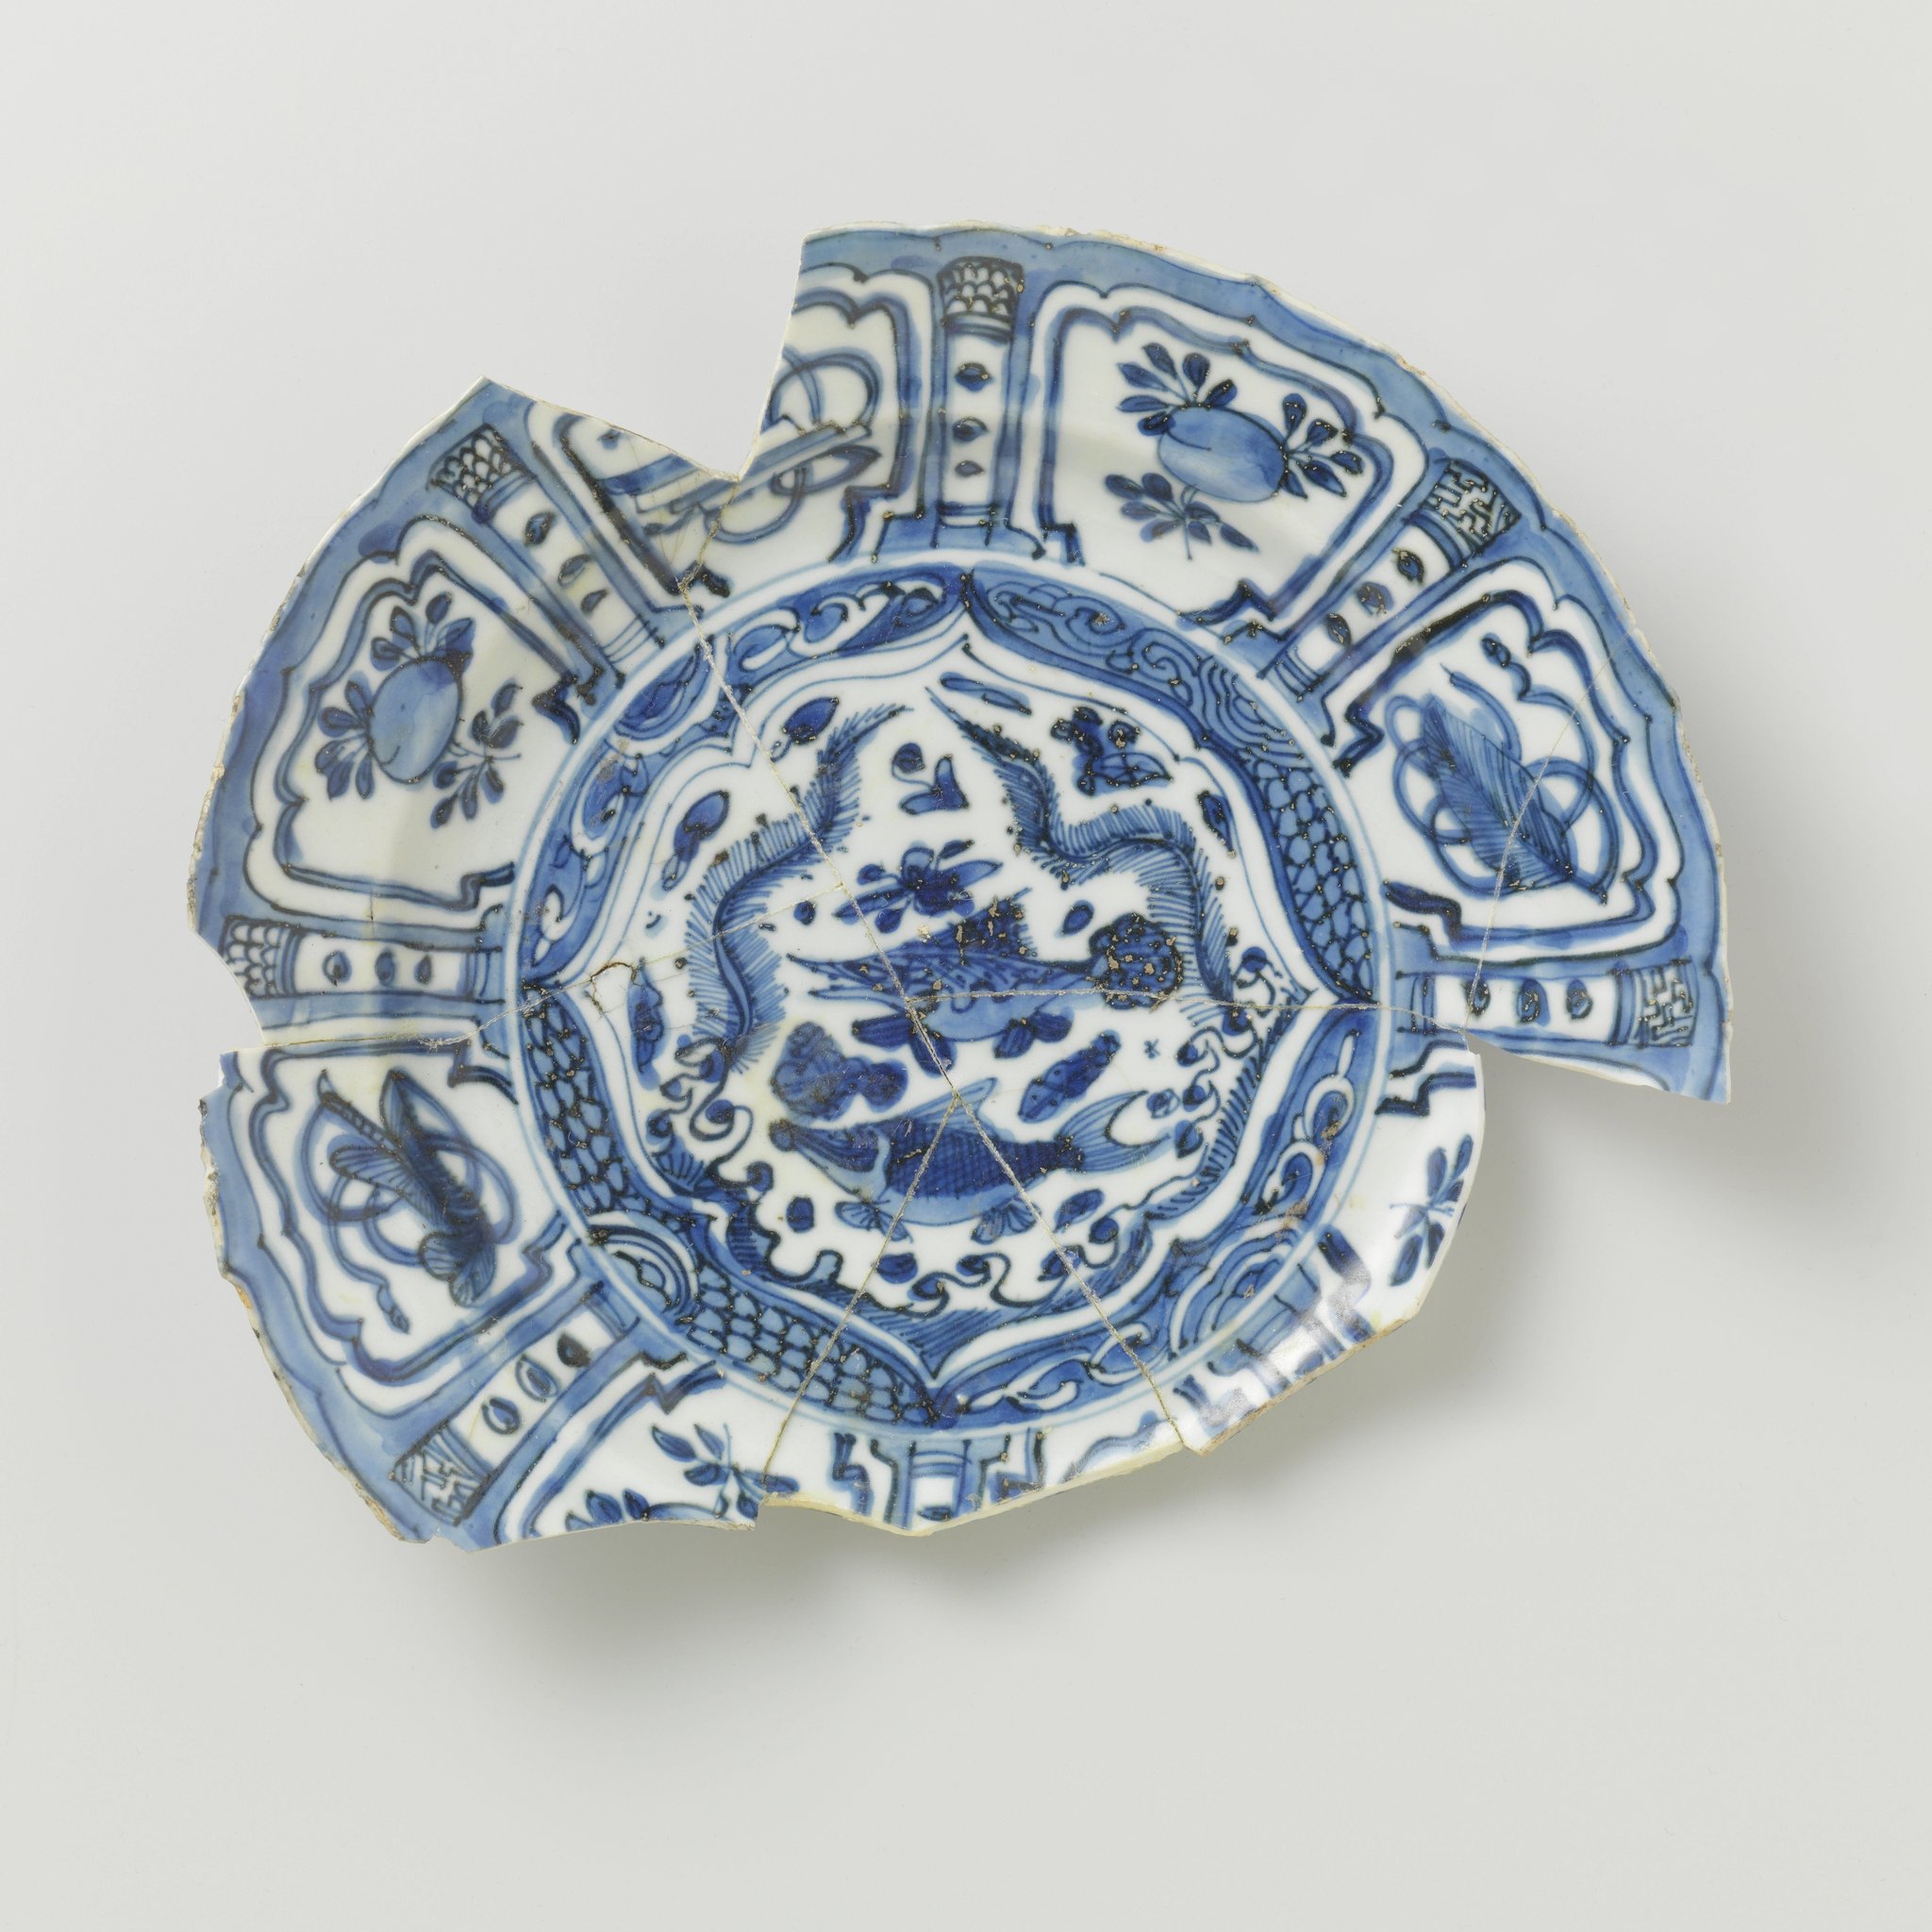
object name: plate dish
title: Bord uit V.O.C.-schip de 'Witte Leeuw'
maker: Anonymous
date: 1613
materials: bone china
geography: jingdezhen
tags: fishes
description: A plate with a flattened rim. A four-sided scalloped medallion with rui heads and radial panels and diaper patterns. A central decoration of two fish (carp) among weeds. Panels decorated with peaches and symbols.